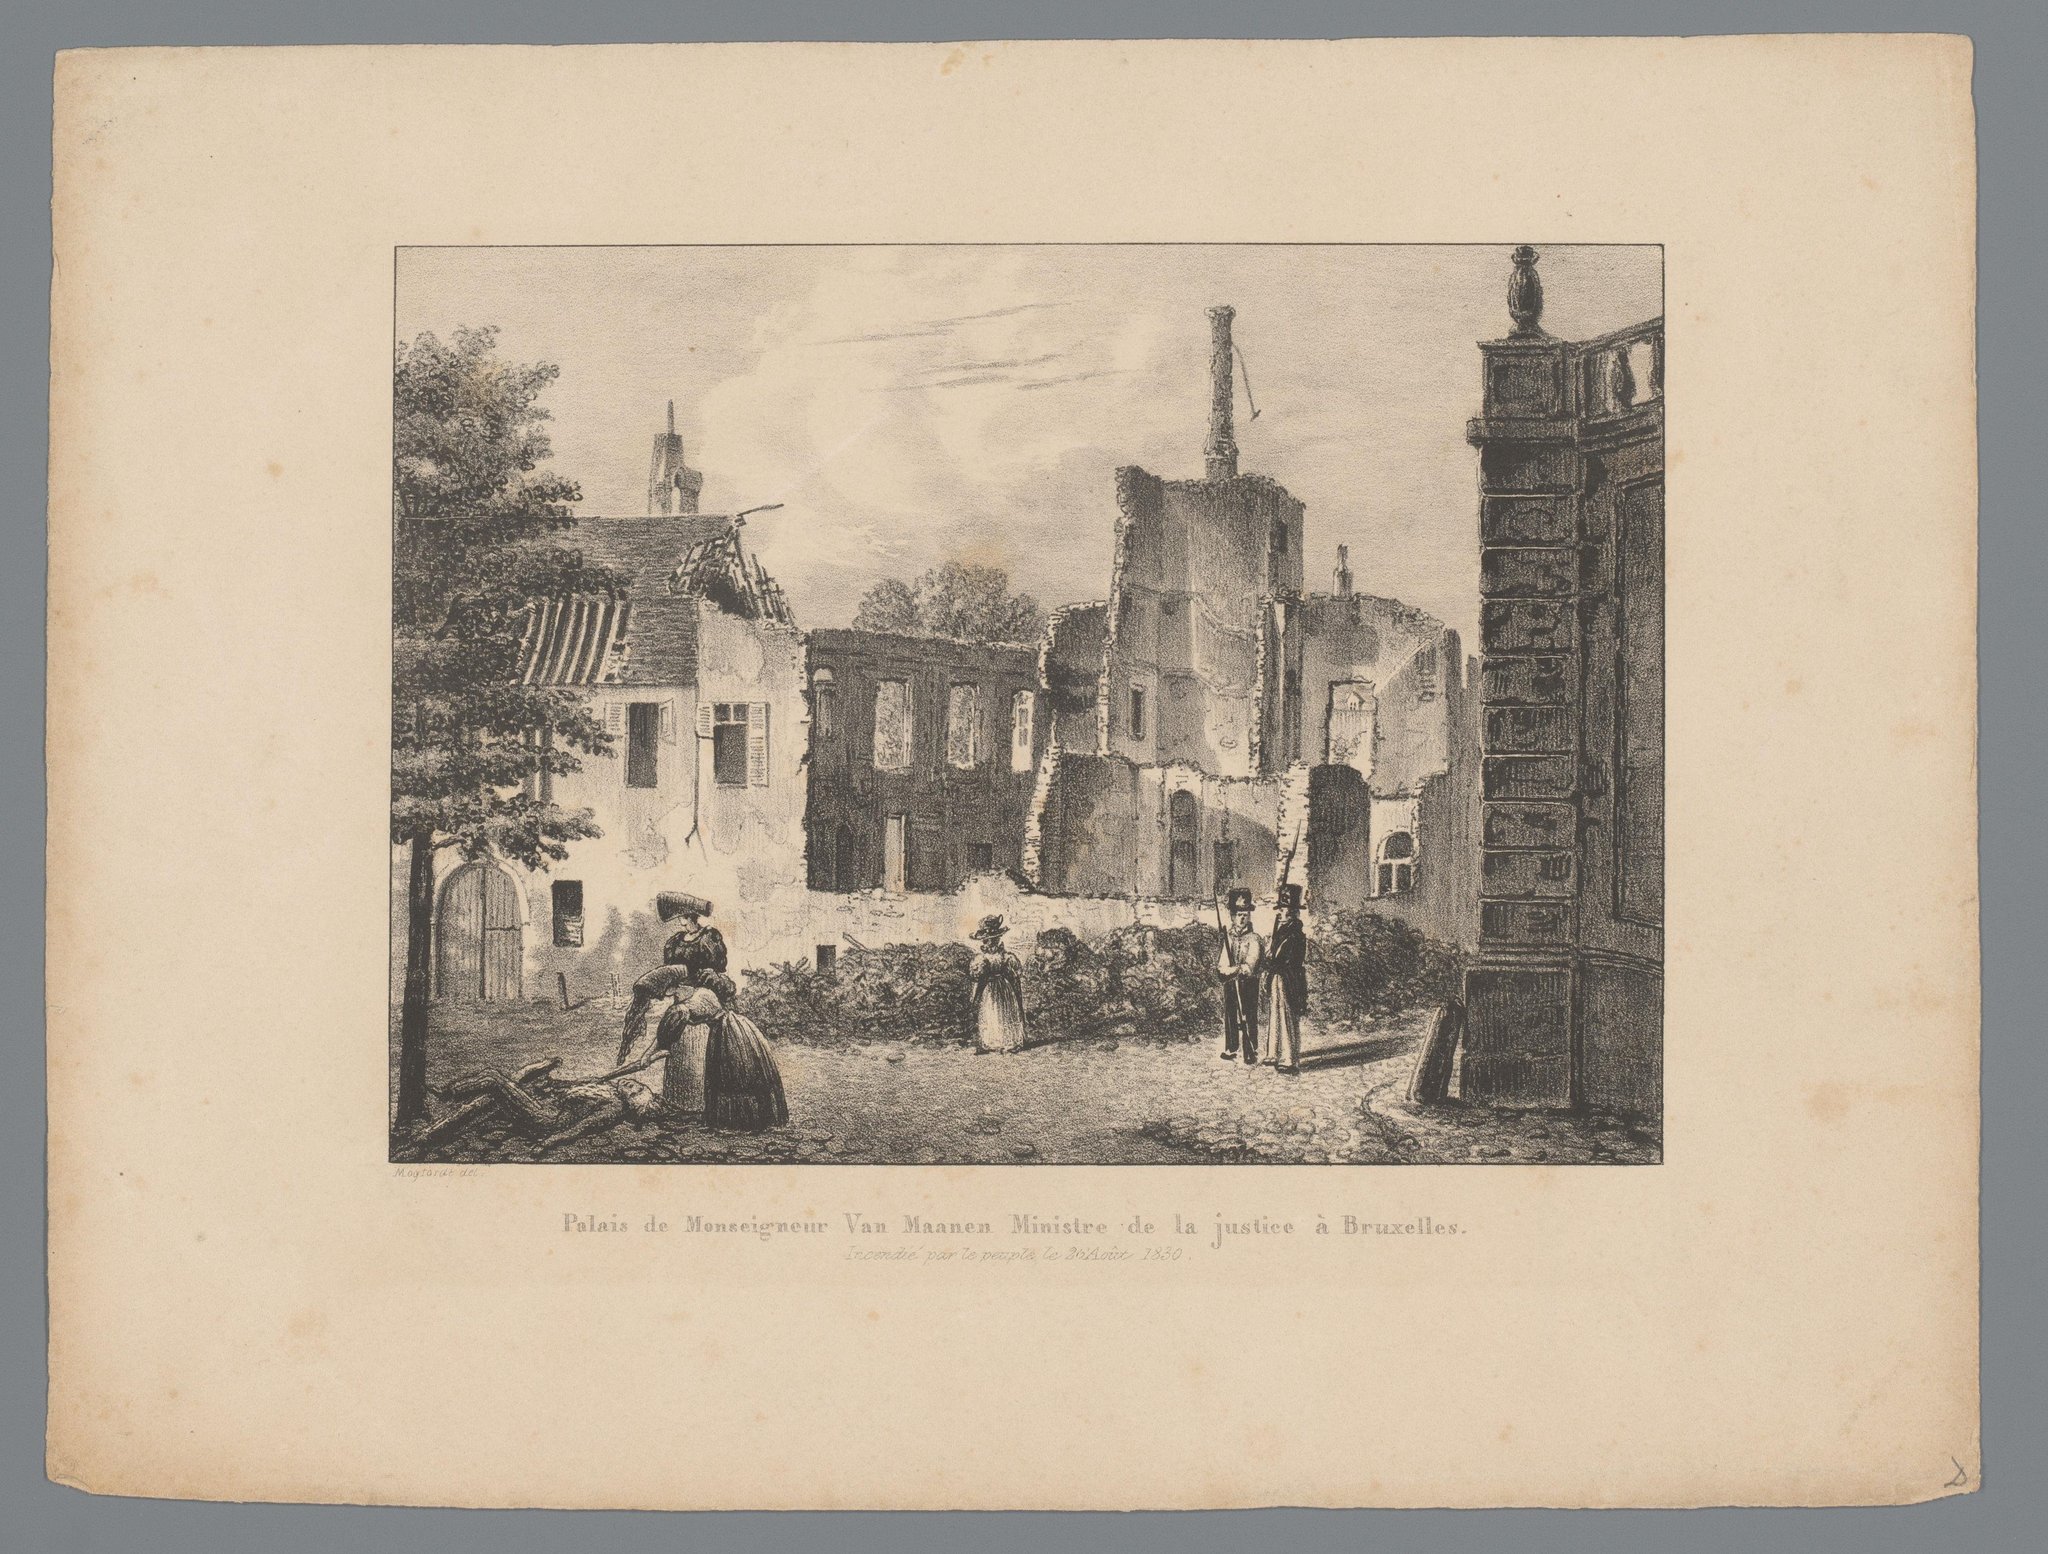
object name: print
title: Prenten toegevoegd aan de serie Evénemens de Bruxelles, Anvers (...) (1831)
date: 1830-1831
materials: paper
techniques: lithograph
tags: the hague, devastated, ruined place or city (~ warfare), street-fights, riots, brussels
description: Onderdeel van een groep prenten uit verschillende andere series verwant aan de platen in het recueil over de gebeurtenissen tijdens de Belgische Revolutie in Brussel, Antwerpen en andere steden in de periode van 25 augustus 1830 tot 27 maart 1831. Uitgegeven in een serie van 23 prenten getiteld: Evénemens de la Belgique Dessinés sur les lieux par des témoins oculaires. Brussel: Jean Baptiste Jobard, [1831].